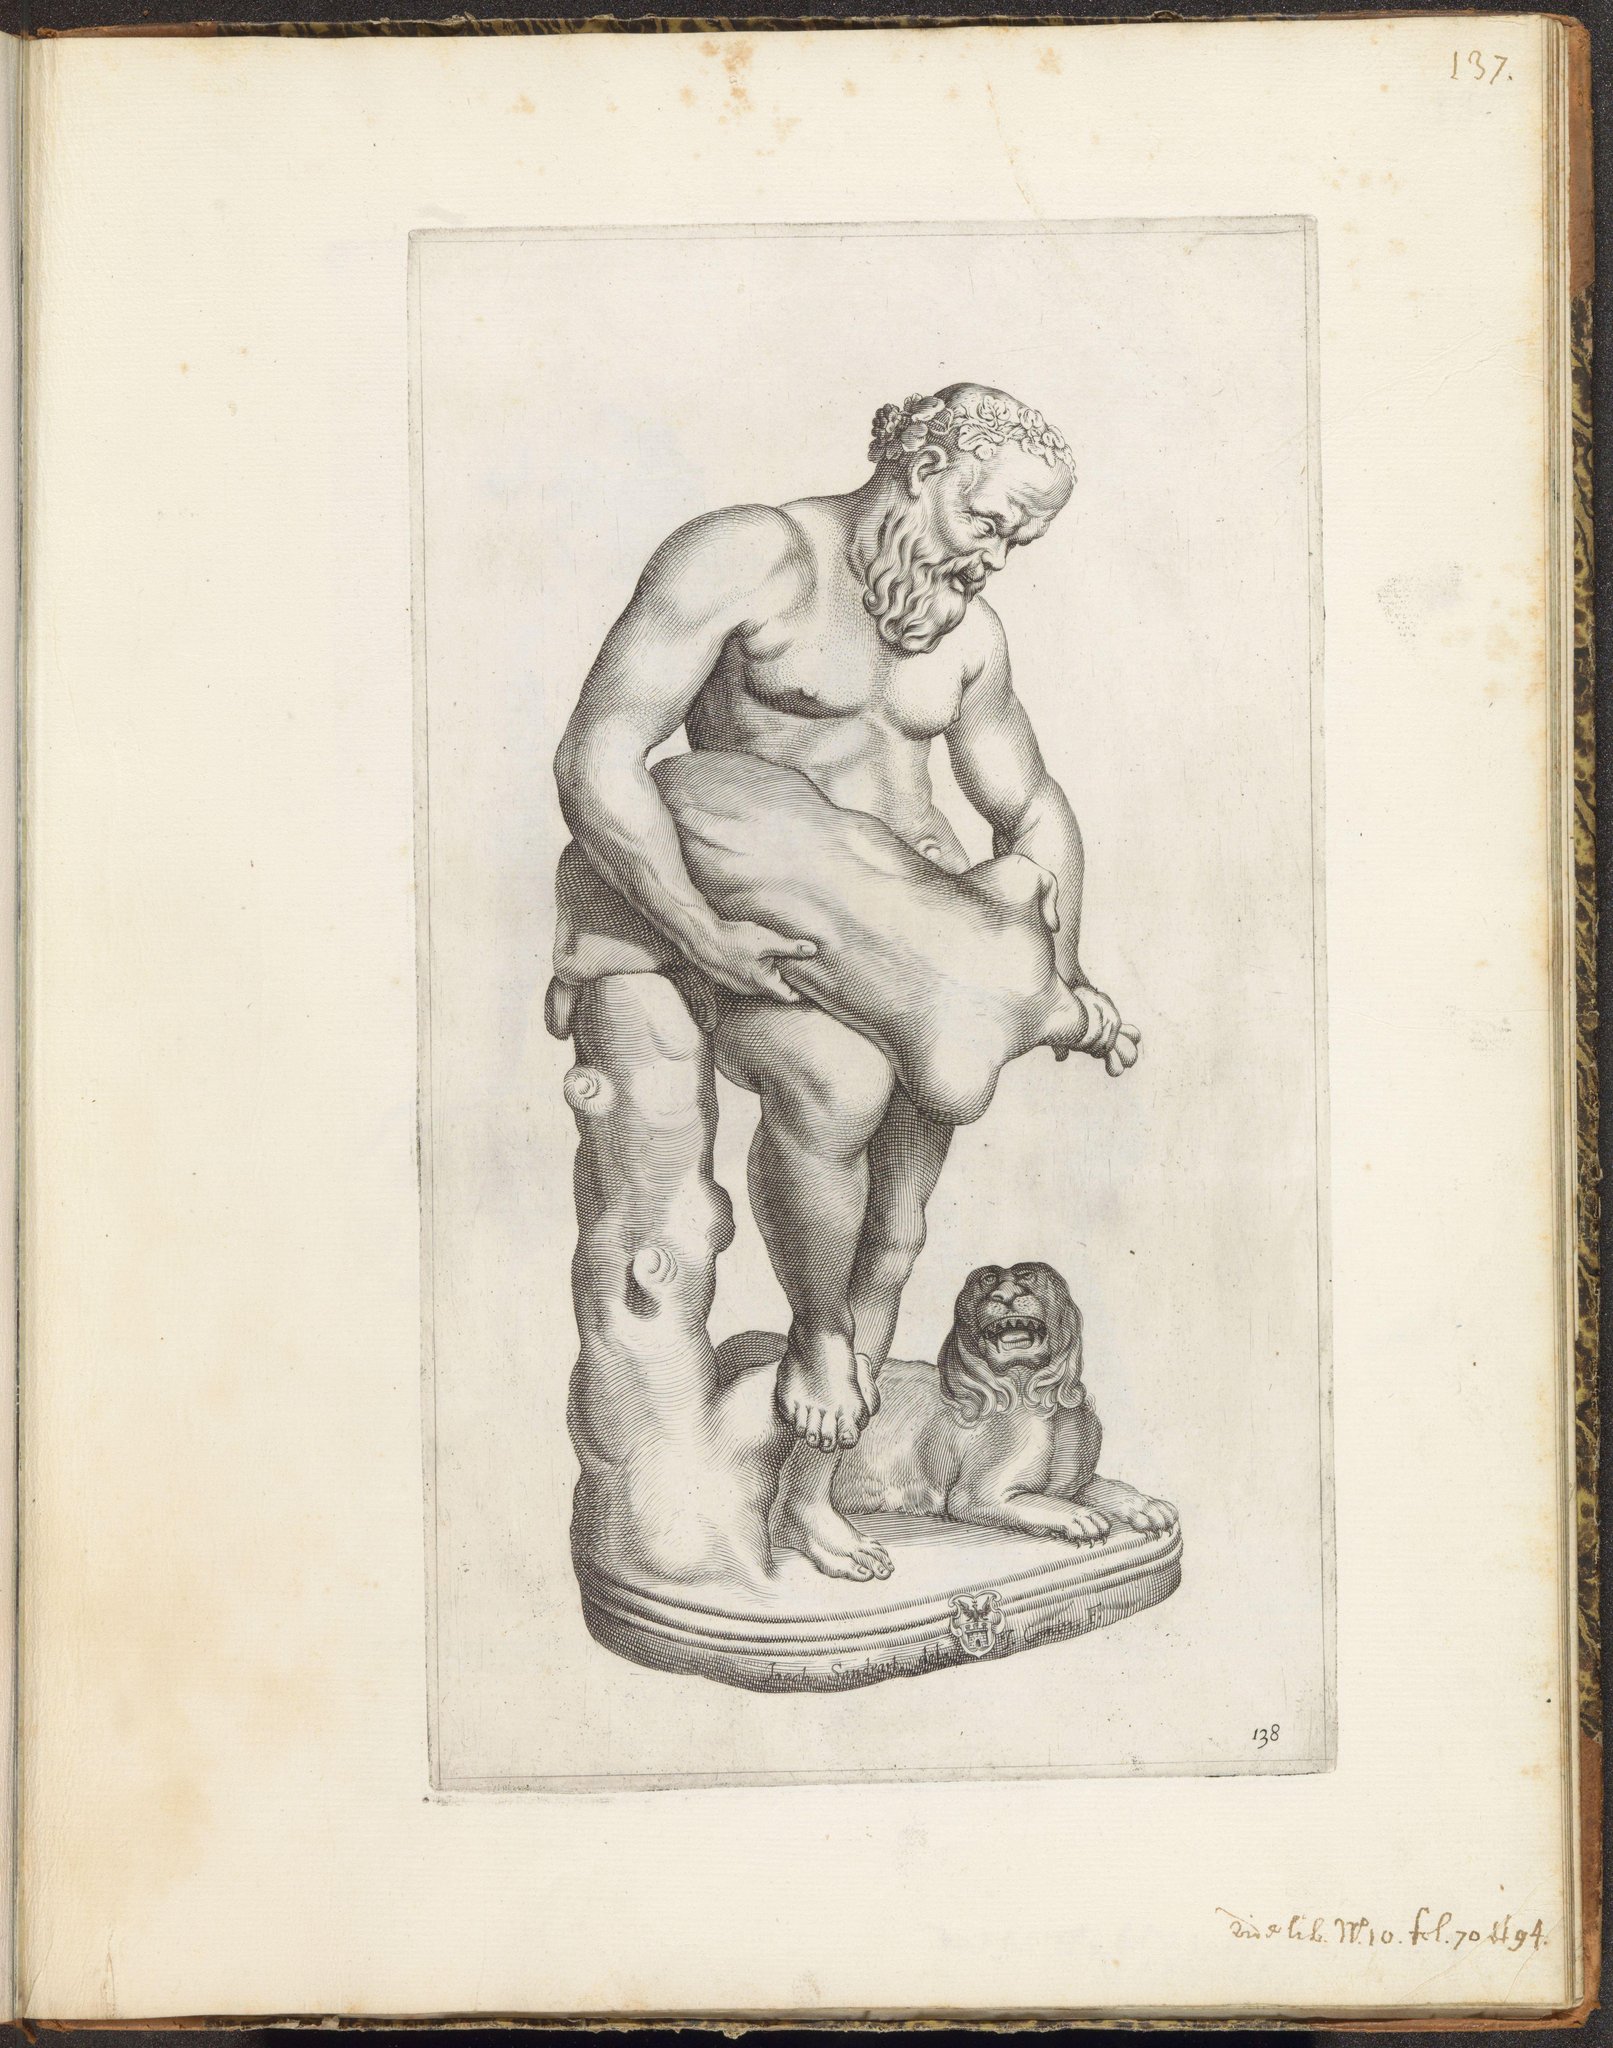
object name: print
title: Galleria Giustiniana del Marchese Vincenzo Giustiniani I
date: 1636-1647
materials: paper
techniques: engraving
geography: rome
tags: (story of) silenus, piece of sculpture, reproduction of a piece of sculpture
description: Standbeeld van Silenus met een zak wijn in de handen. Naast hem een tijger. Midden onder op de basis het wapenschild van Vincenzo Giustiniani. Prent maakt deel uit van een album met een serie prenten naar de sculpturen in de verzameling in de Galleria Giustiniani te Rome.